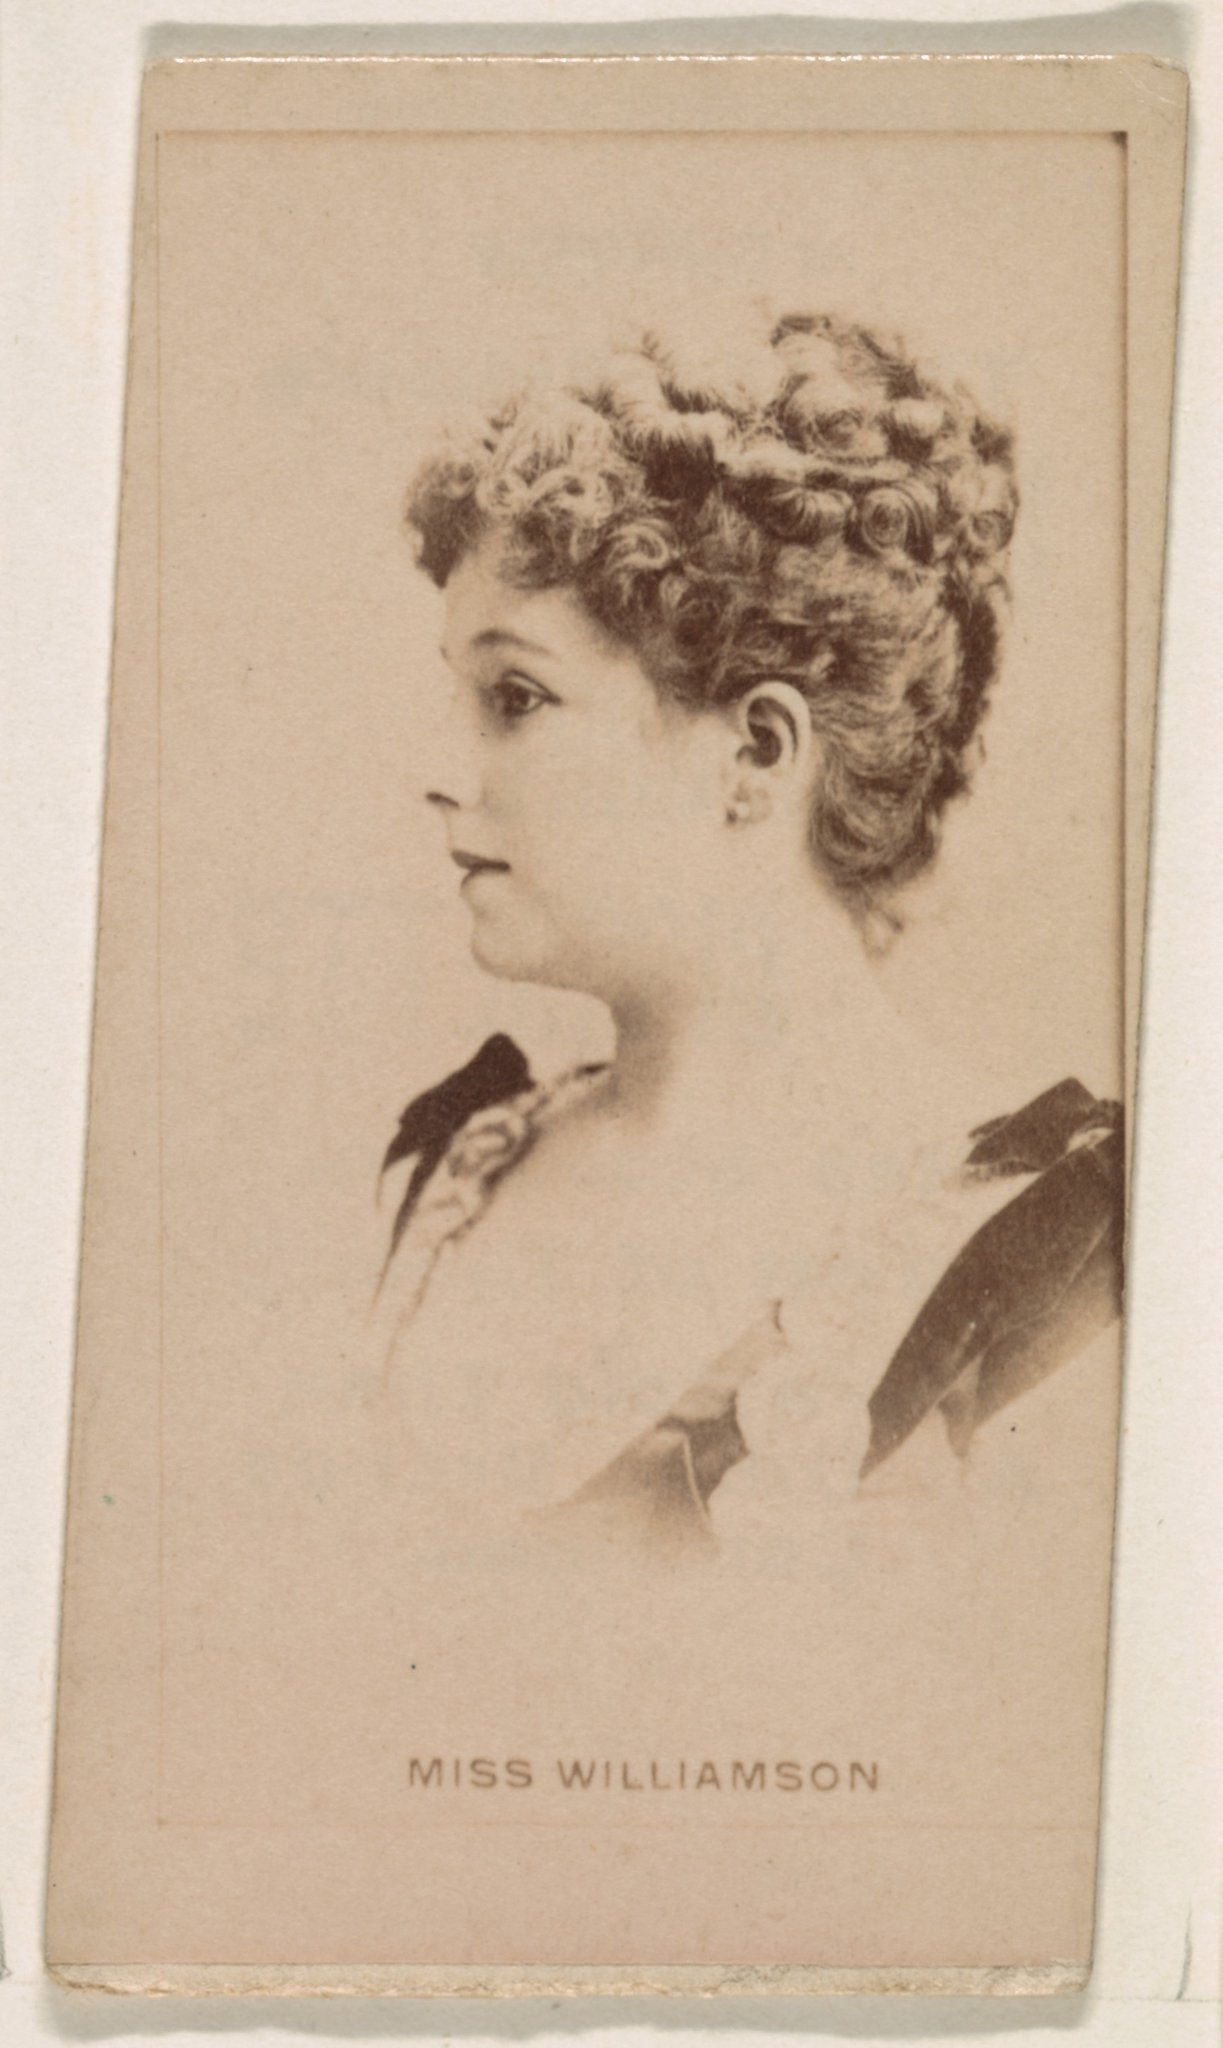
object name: photograph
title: Miss Williamson, from the Actresses series (N245) issued by Kinney Brothers to promote Sweet Caporal Cigarettes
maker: kinney brothers tobacco company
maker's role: publisher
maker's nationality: american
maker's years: 1869-2011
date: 1890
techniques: albumen silver print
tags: women,actresses